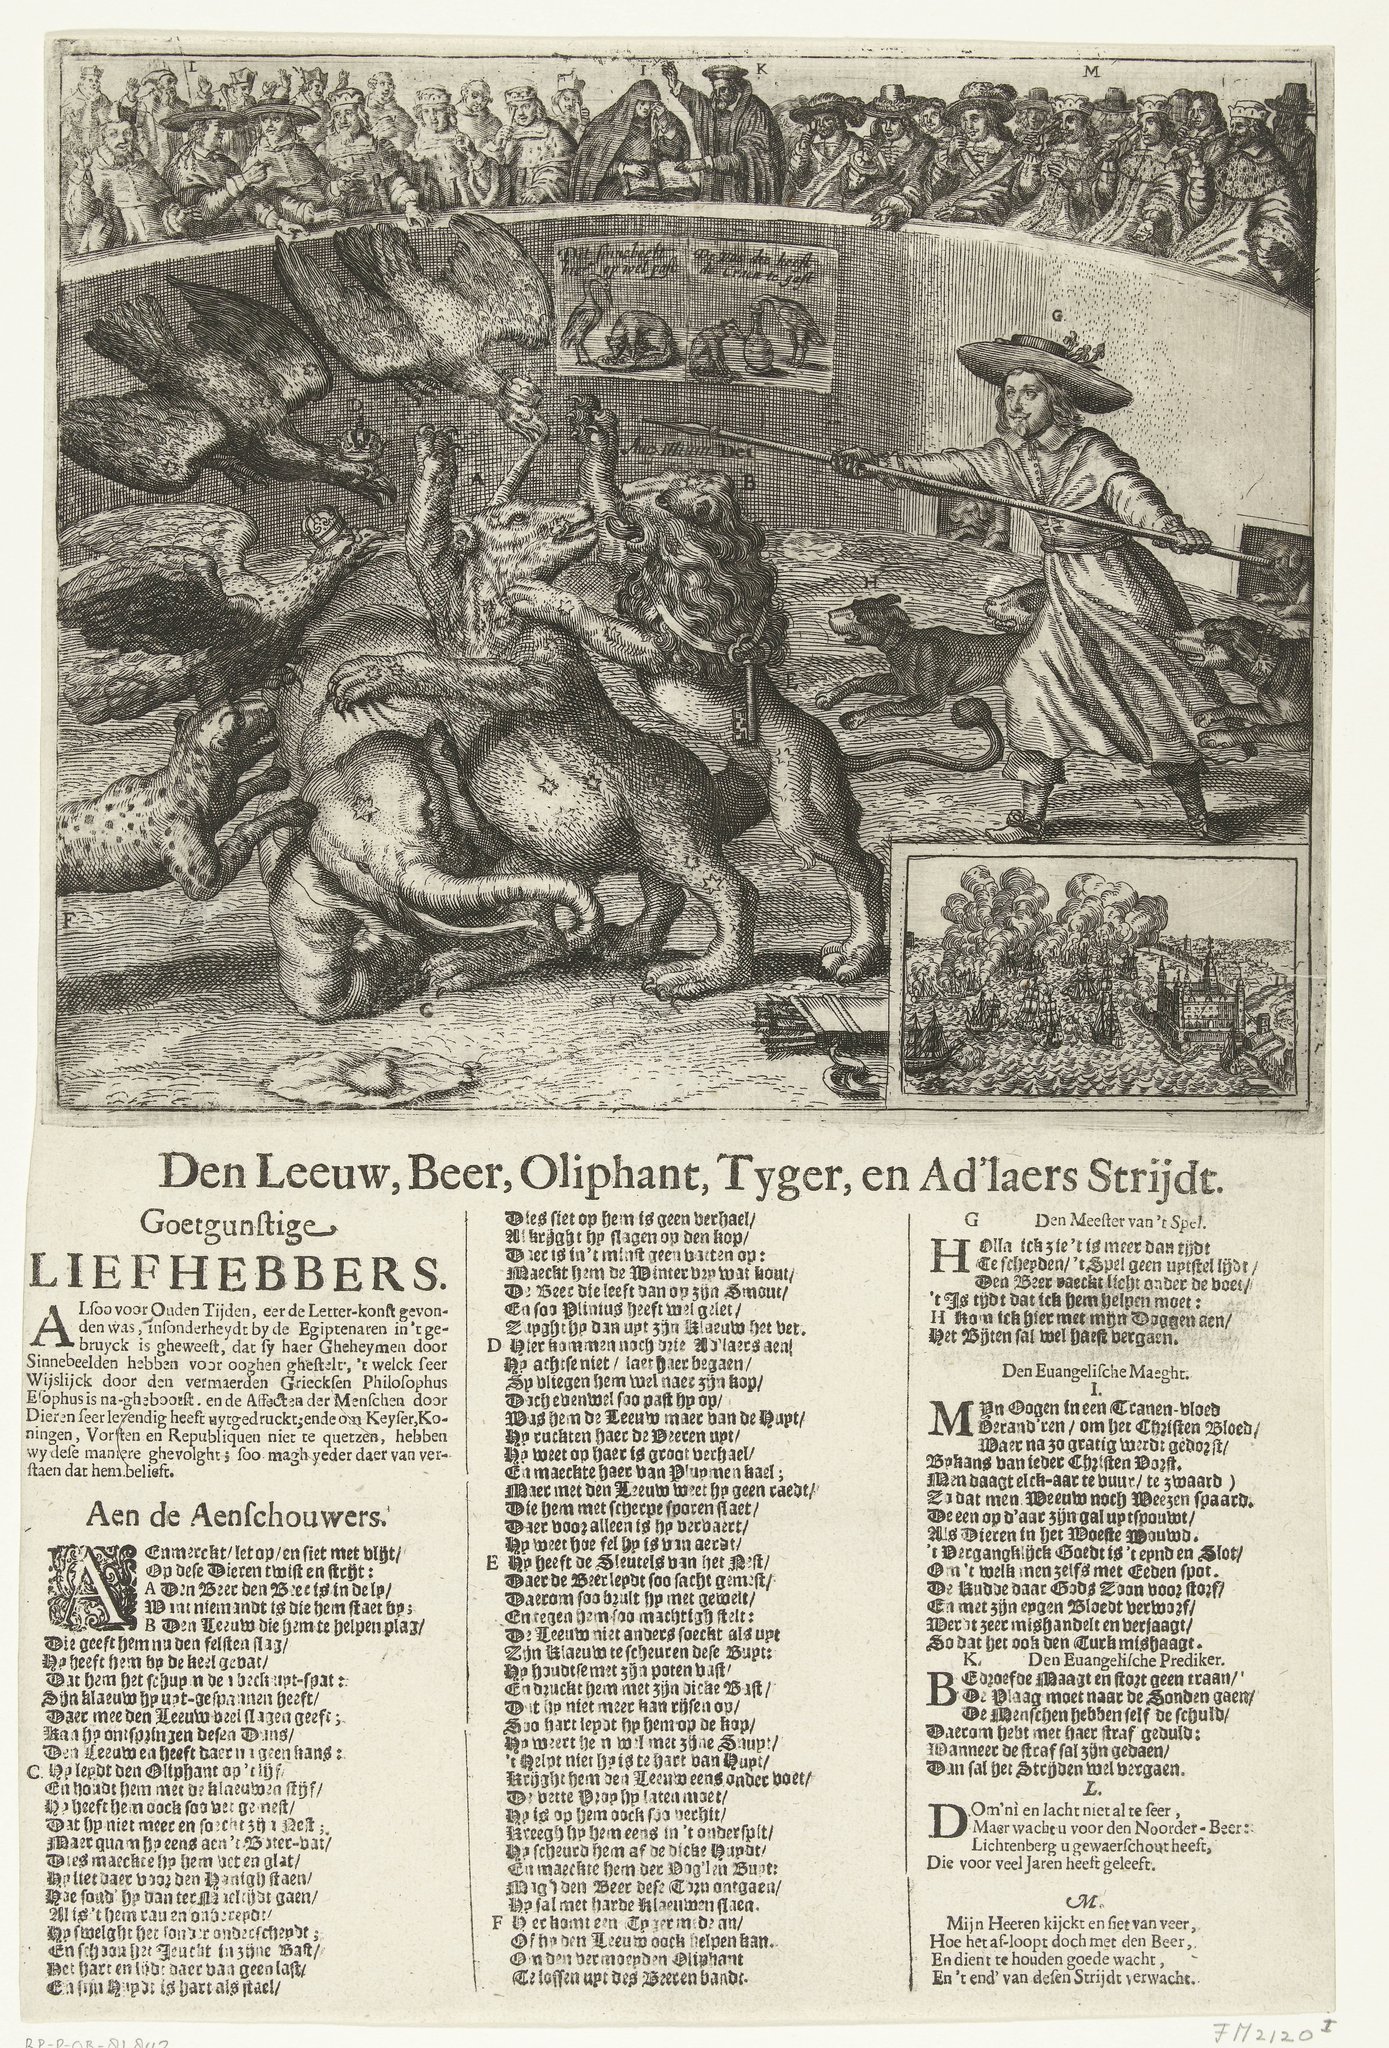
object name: propagandaprent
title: Den Leeuw, Beer, Oliphant, Tyger, en Ad'laers Strijdt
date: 1658-1659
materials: paper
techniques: engraving, etching, letterpress printing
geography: northern netherlands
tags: oliver cromwell, animals (+ fighting animals; aggressive relations), circus ring, copenhagen (city)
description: Allegorie op de Noordse Oorlog, ca. 1658. In een arena een gevecht tussen een leeuw (Nederland), beer (Zweden), olifant (Denemarken), een tijger en drie adelaars (Polen, Pruisen en het Duitse Rijk). Het gevecht wordt aangestuurd door Cromwell met zijn honden. De Europese vorsten kijken als publiek toe, in het midden de evangelische maagd en de evangelische prediker. Rechtsonder een inzet met een gevecht tussen schepen bij een kasteel Kronborg. Onder de plaat is een tekst gedrukt in 3 kolommen in het Nederlands met een verklaring van de letters A-M. Zie ook een Duitse versie van deze prent gedateerd 1659.